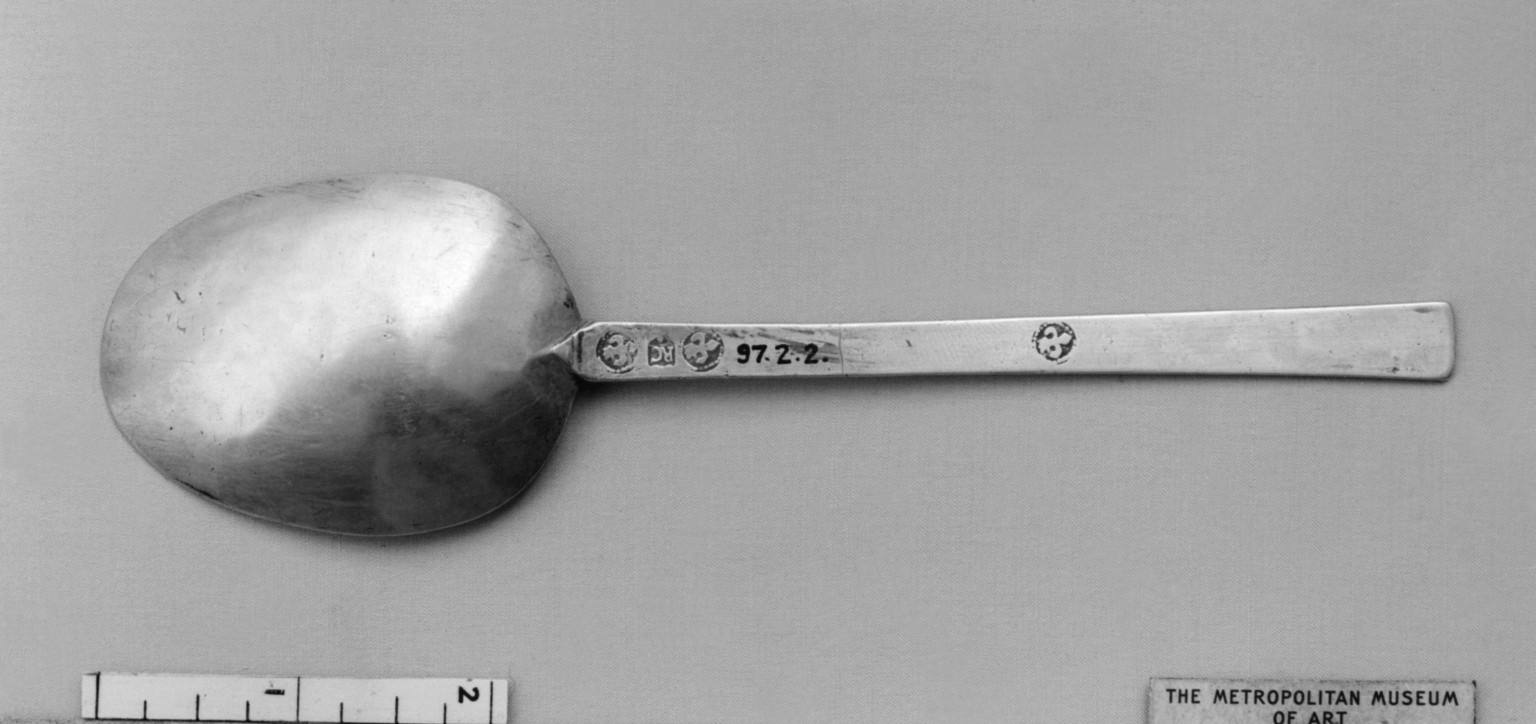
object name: spoon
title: Puritan spoon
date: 1670-1690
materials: silver